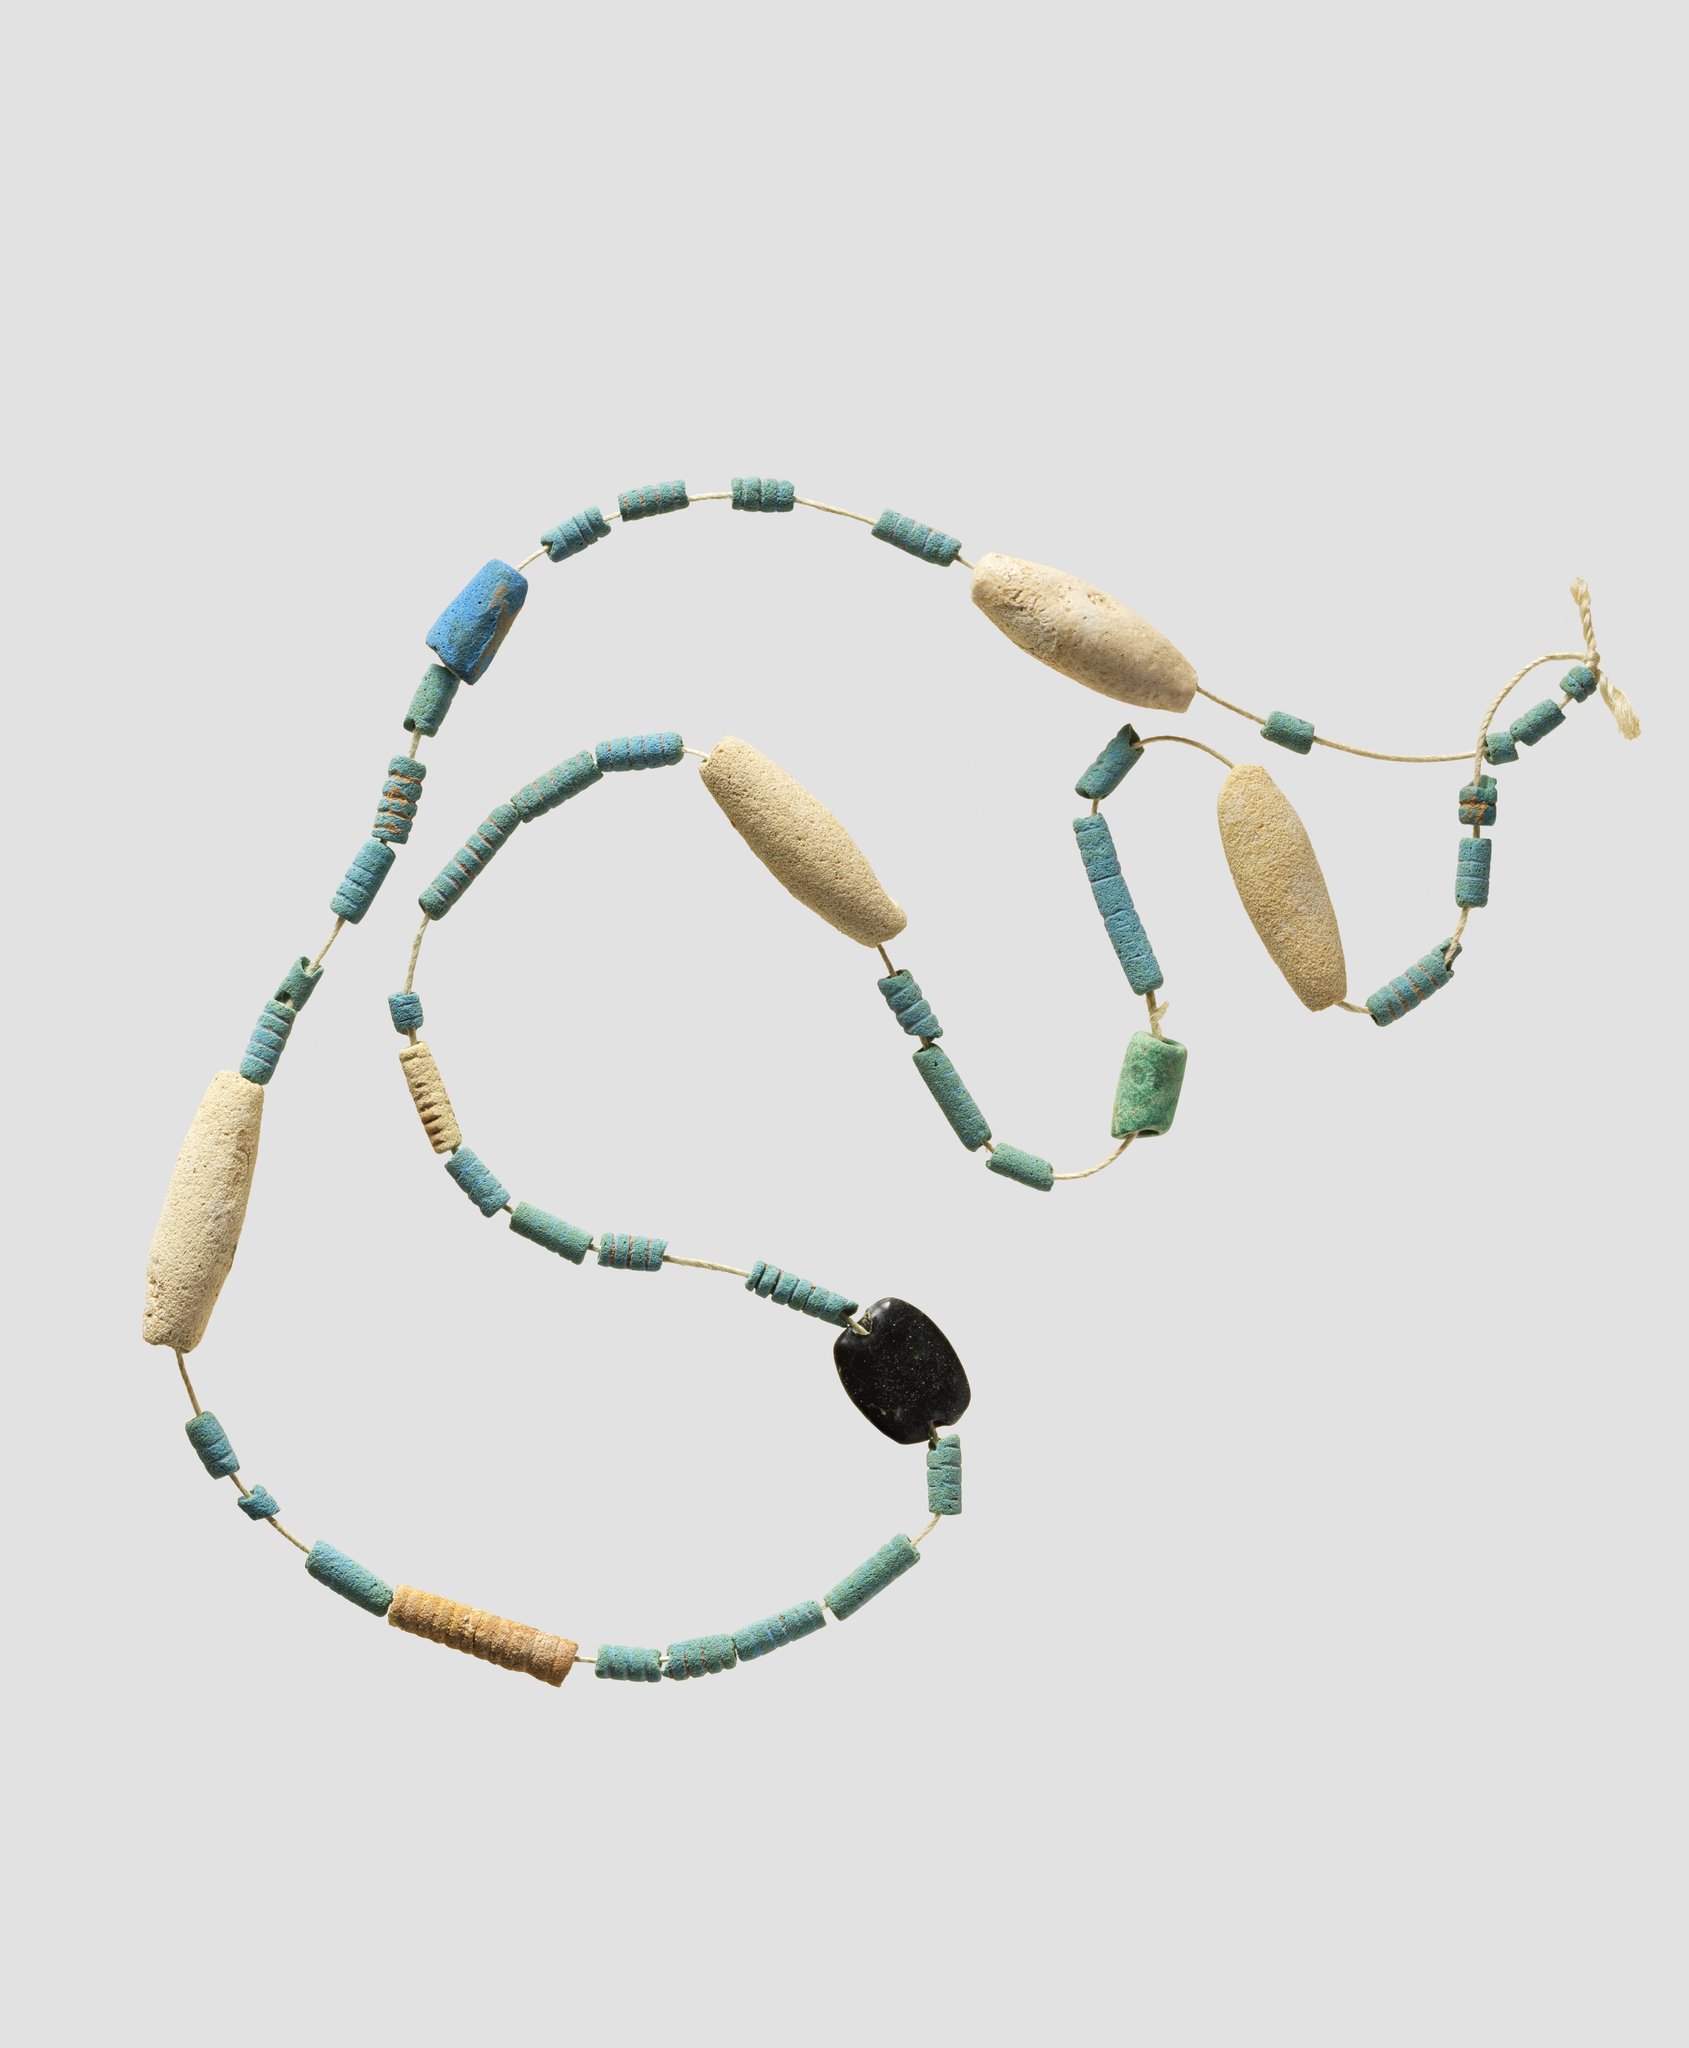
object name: bead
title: Beads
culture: assyrian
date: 900-601 BCE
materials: faience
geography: mesopotamia